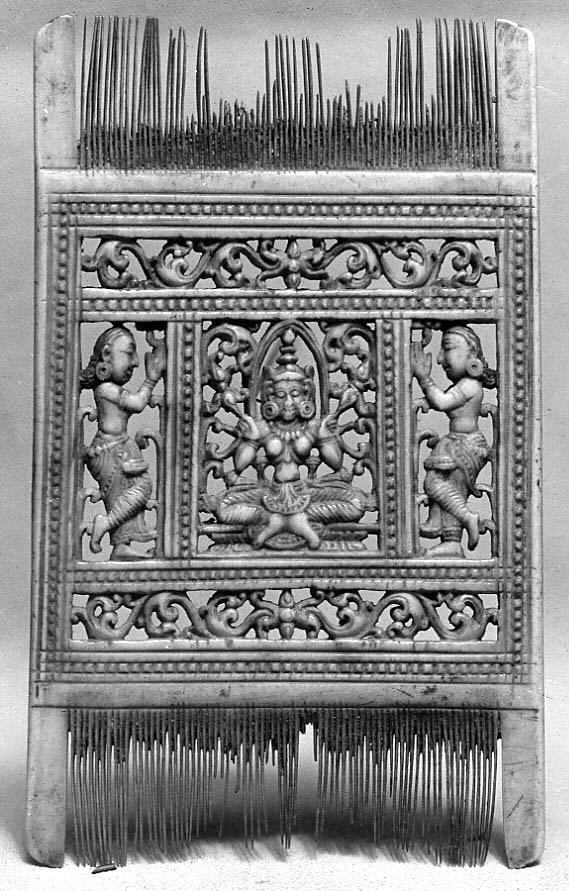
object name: comb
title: Double Comb with Lakshmi (?)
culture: sri lankan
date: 1601-1800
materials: ivory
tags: goddess